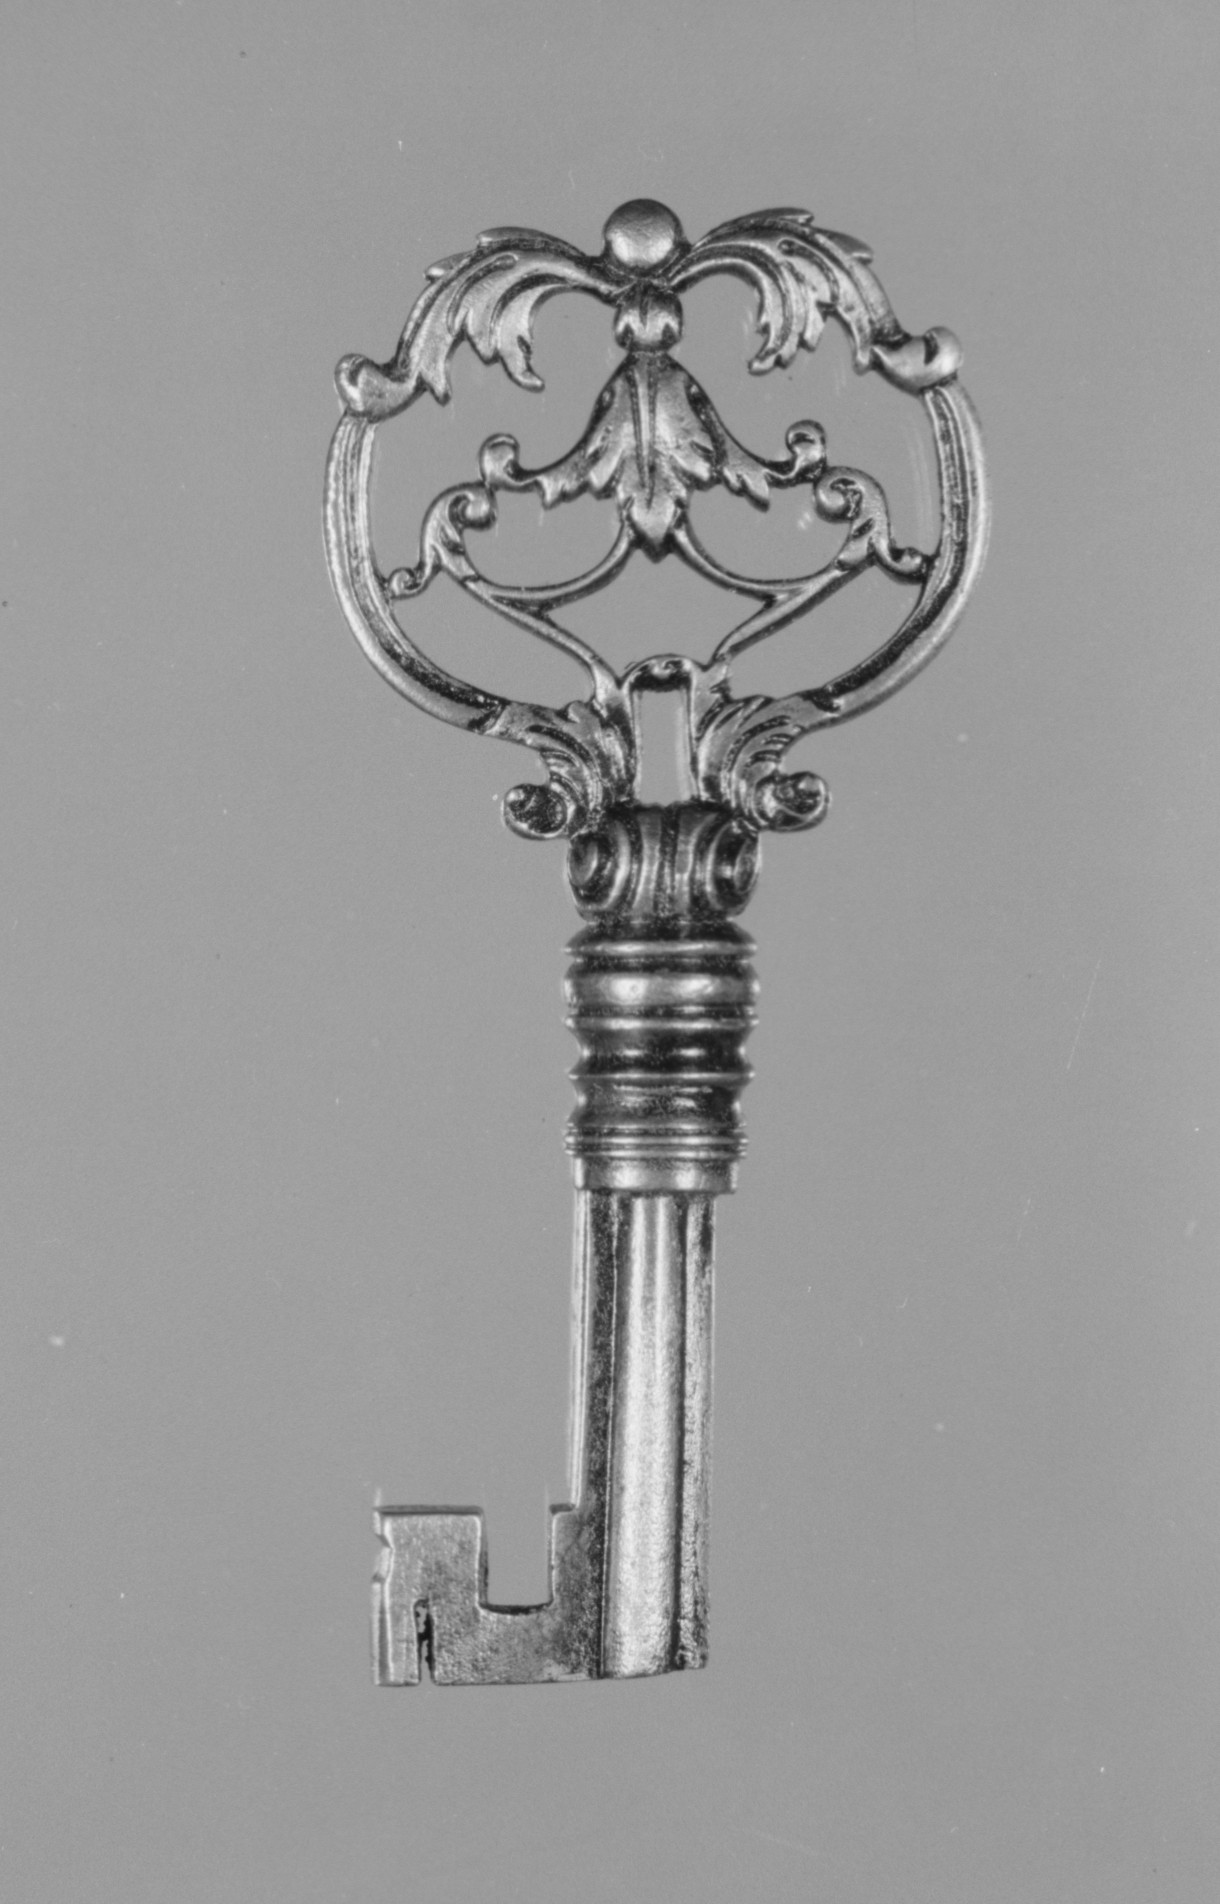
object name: key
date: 1801-1900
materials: iron